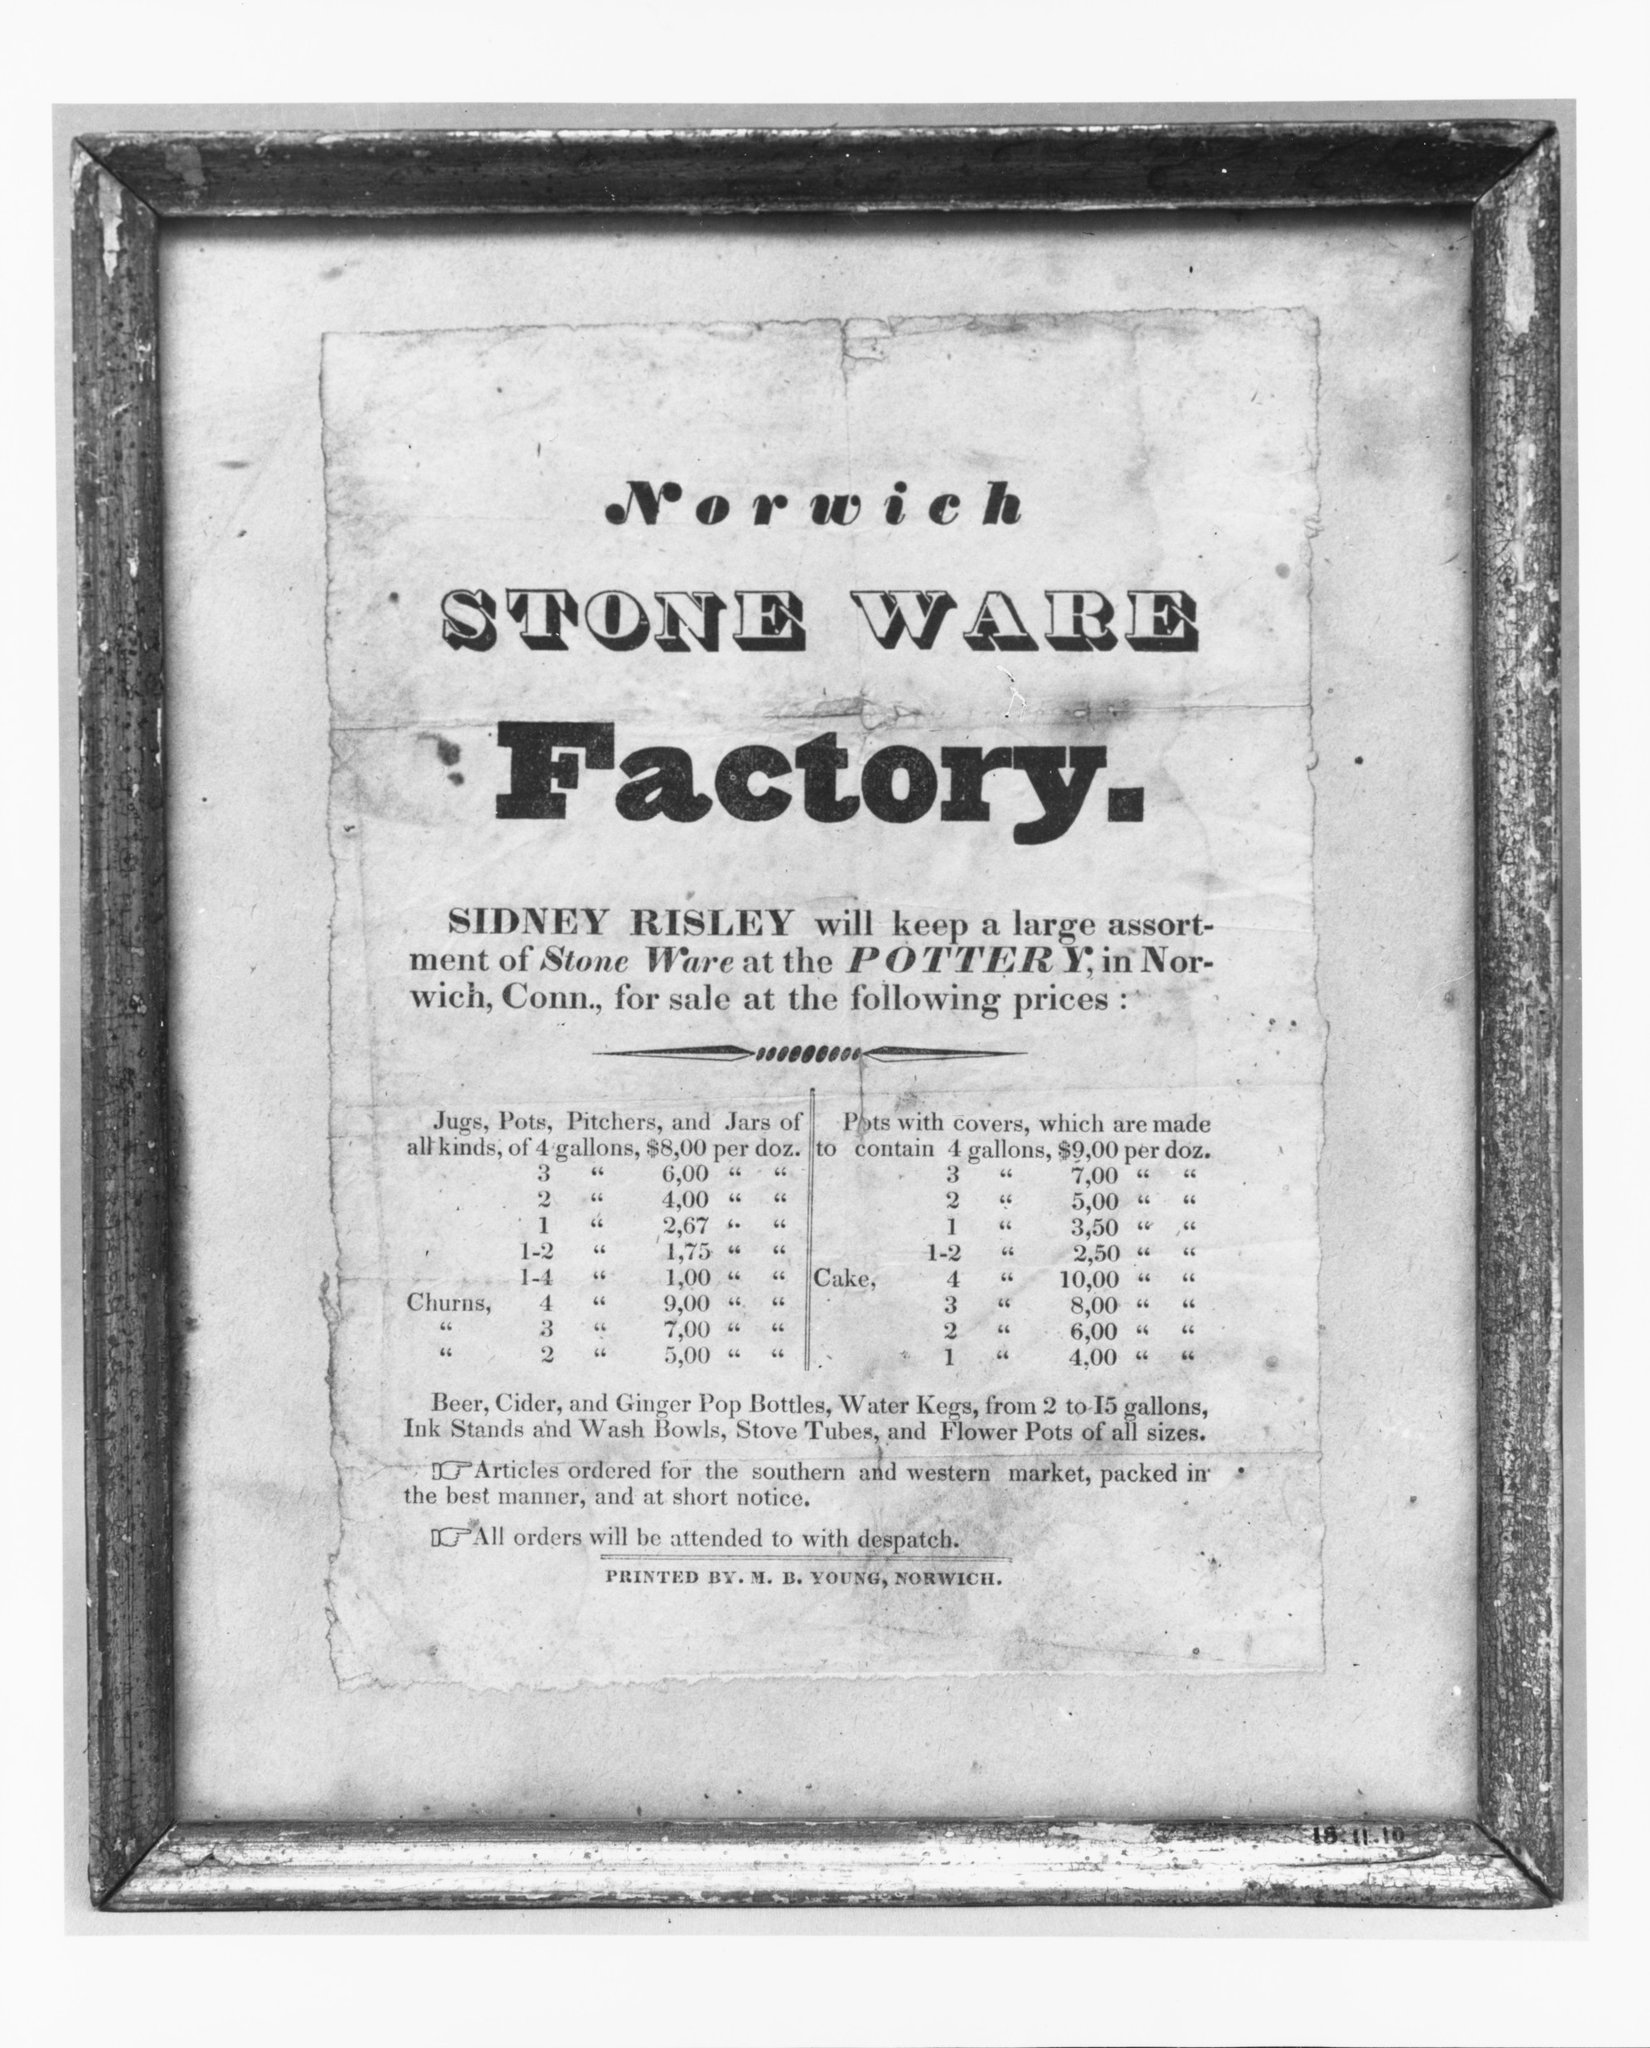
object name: advertisement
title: Advertisement for Norwich Stone Ware Factory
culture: american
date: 1770-1800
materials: paper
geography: united states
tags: advertisements